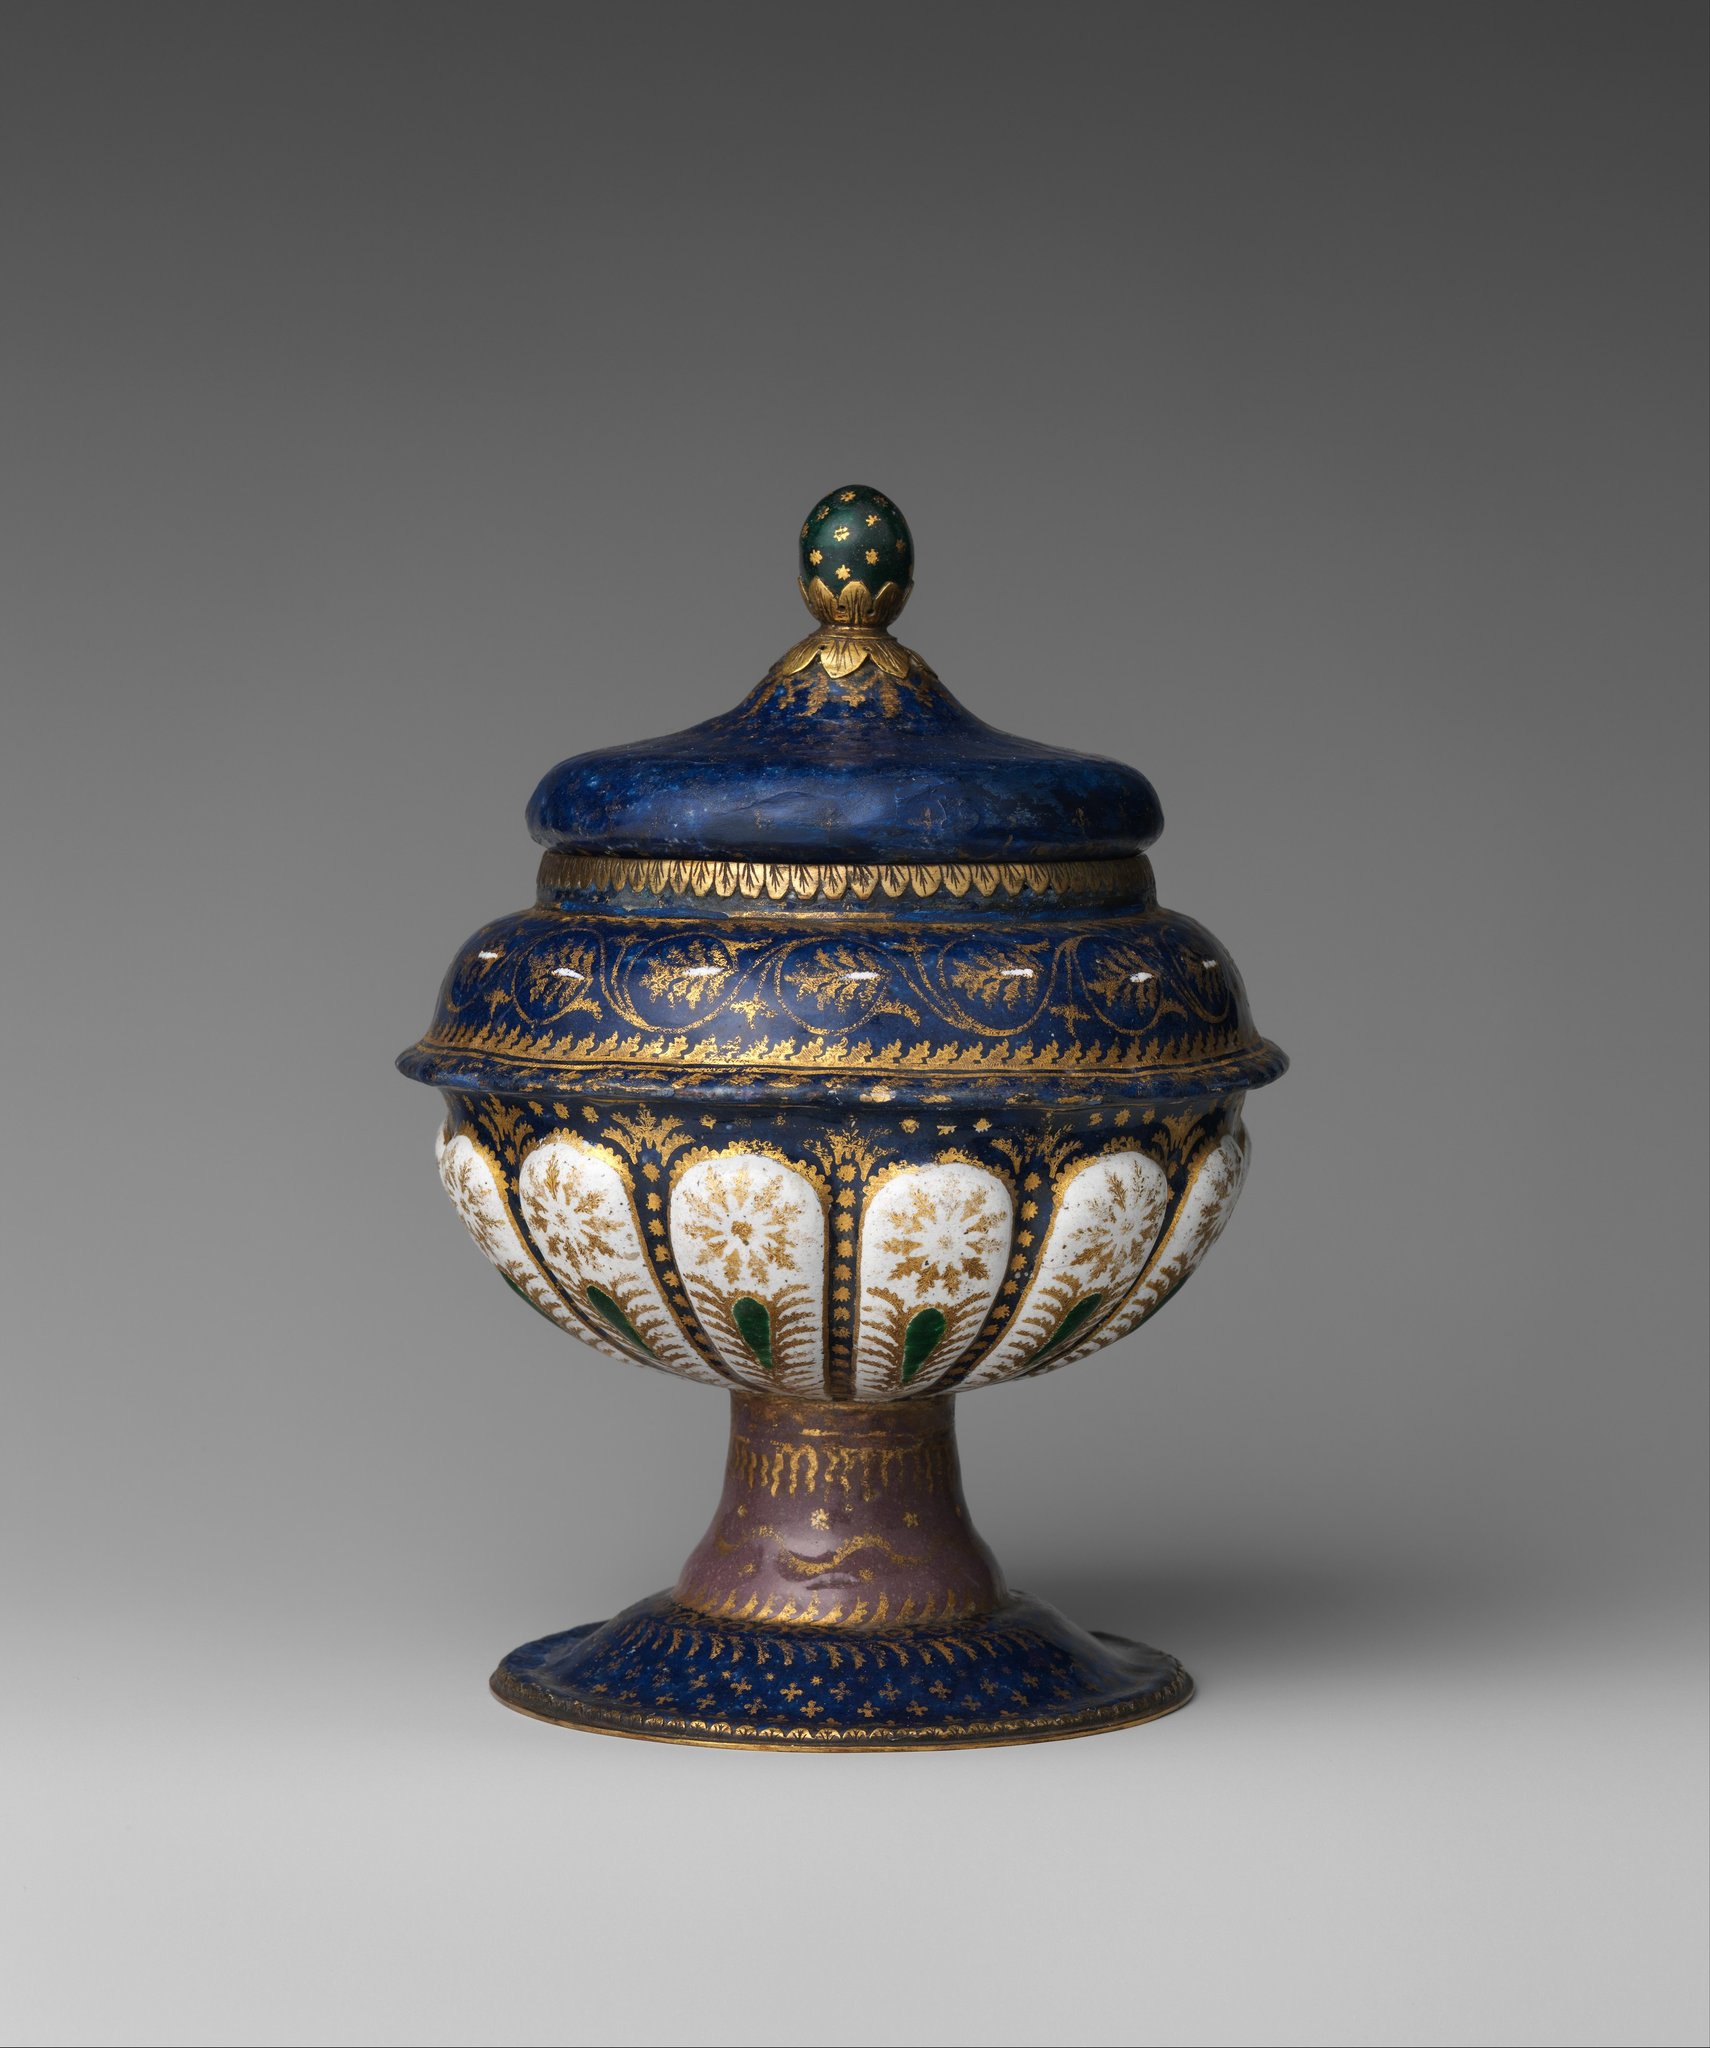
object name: cup with cover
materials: brass, copper, enamel, gilt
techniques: painting